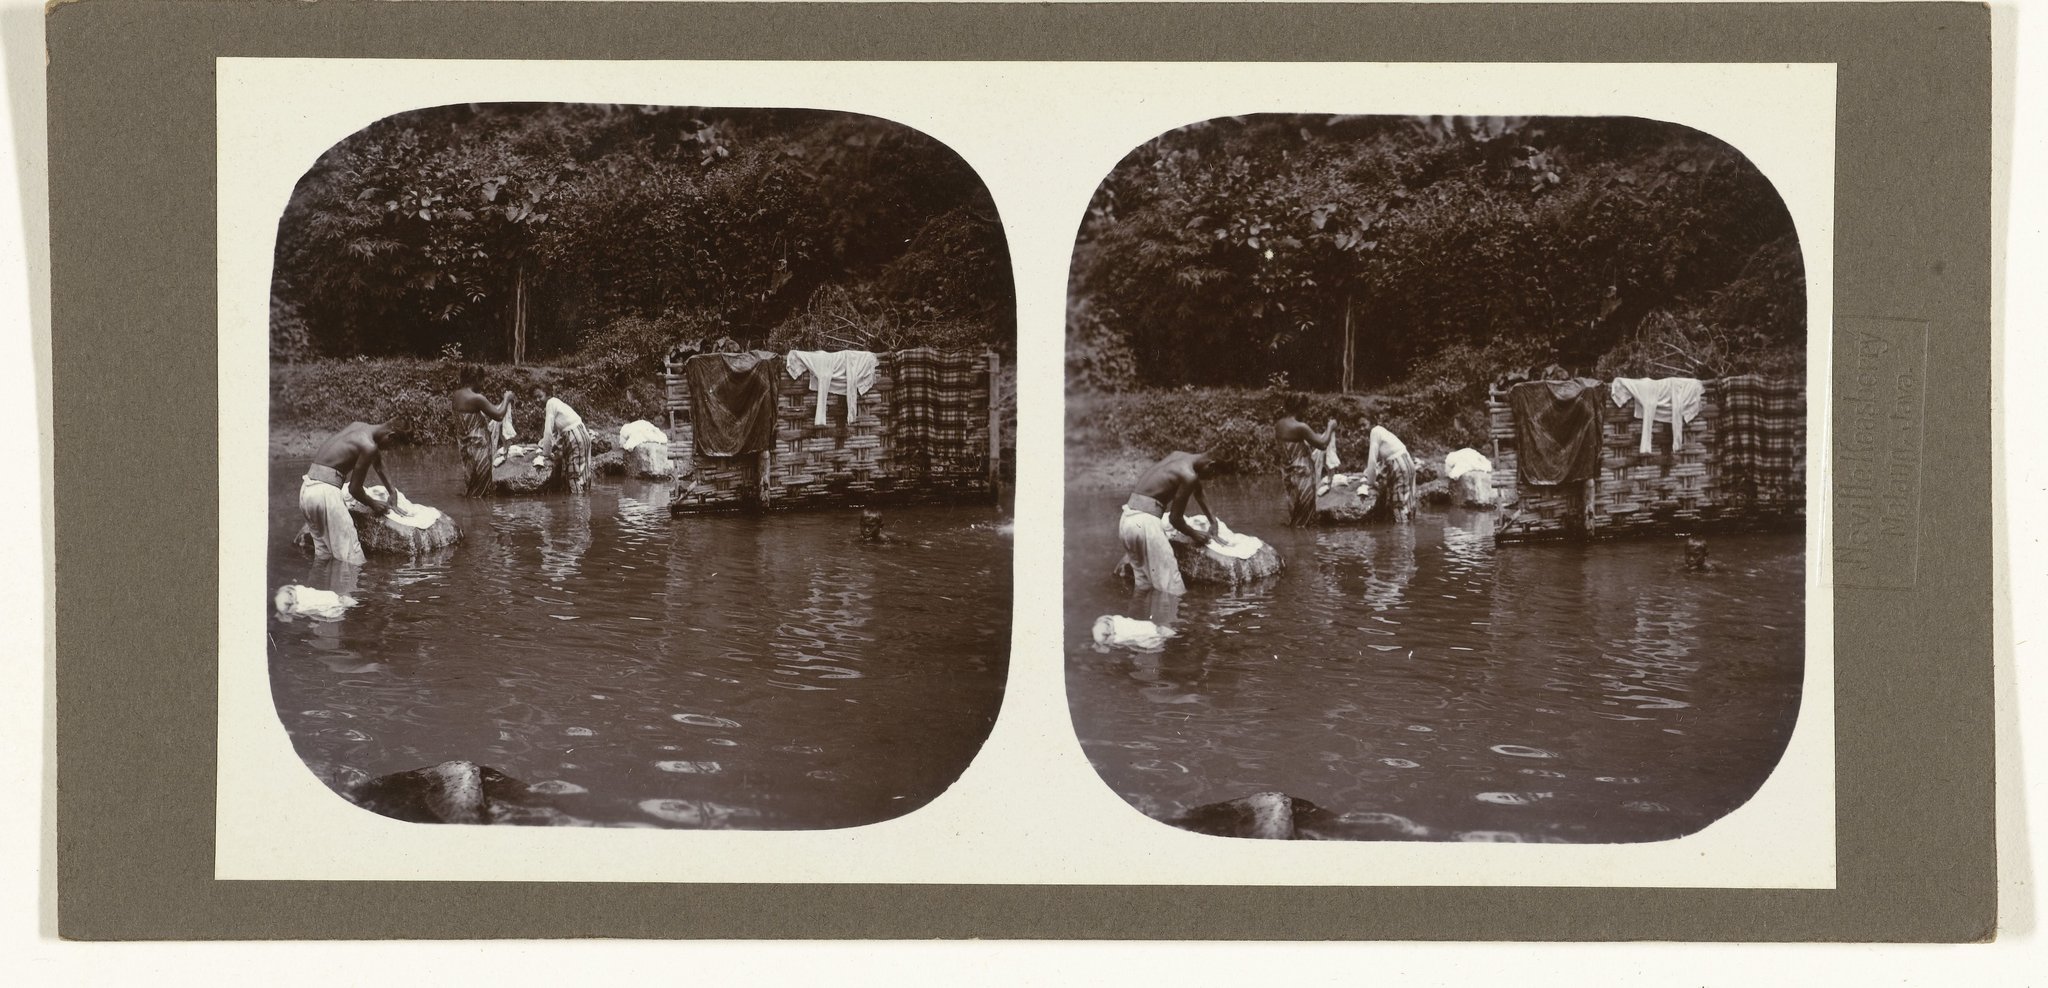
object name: photograph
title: Mensen die de was doen op stenen in de rivier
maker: neville keasberry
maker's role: fotograaf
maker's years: 1866-1944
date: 1900-1935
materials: cardboard, paper, photographic support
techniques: albumen print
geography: malang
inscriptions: signature: ‘Neville Keasberry, Malang (Java)’